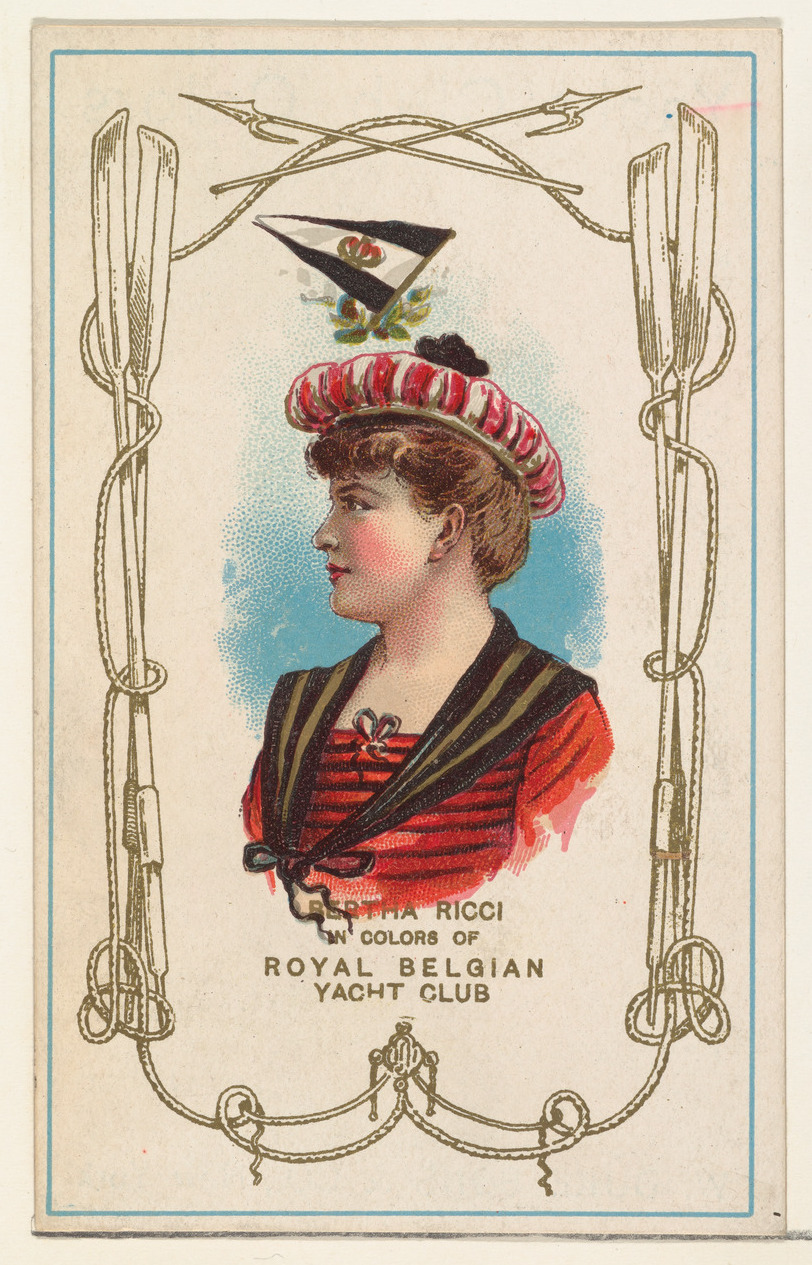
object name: print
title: Bertha Ricci in Colors of Royal Belgian Yacht Club, from the Yacht Colors of the World series (N140) issued by Duke Sons & Co. to promote Honest Long Cut Tobacco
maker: w. duke, sons & co.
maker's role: publisher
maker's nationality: american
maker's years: 1870-1920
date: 1890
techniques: color lithograph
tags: profiles,women,flags